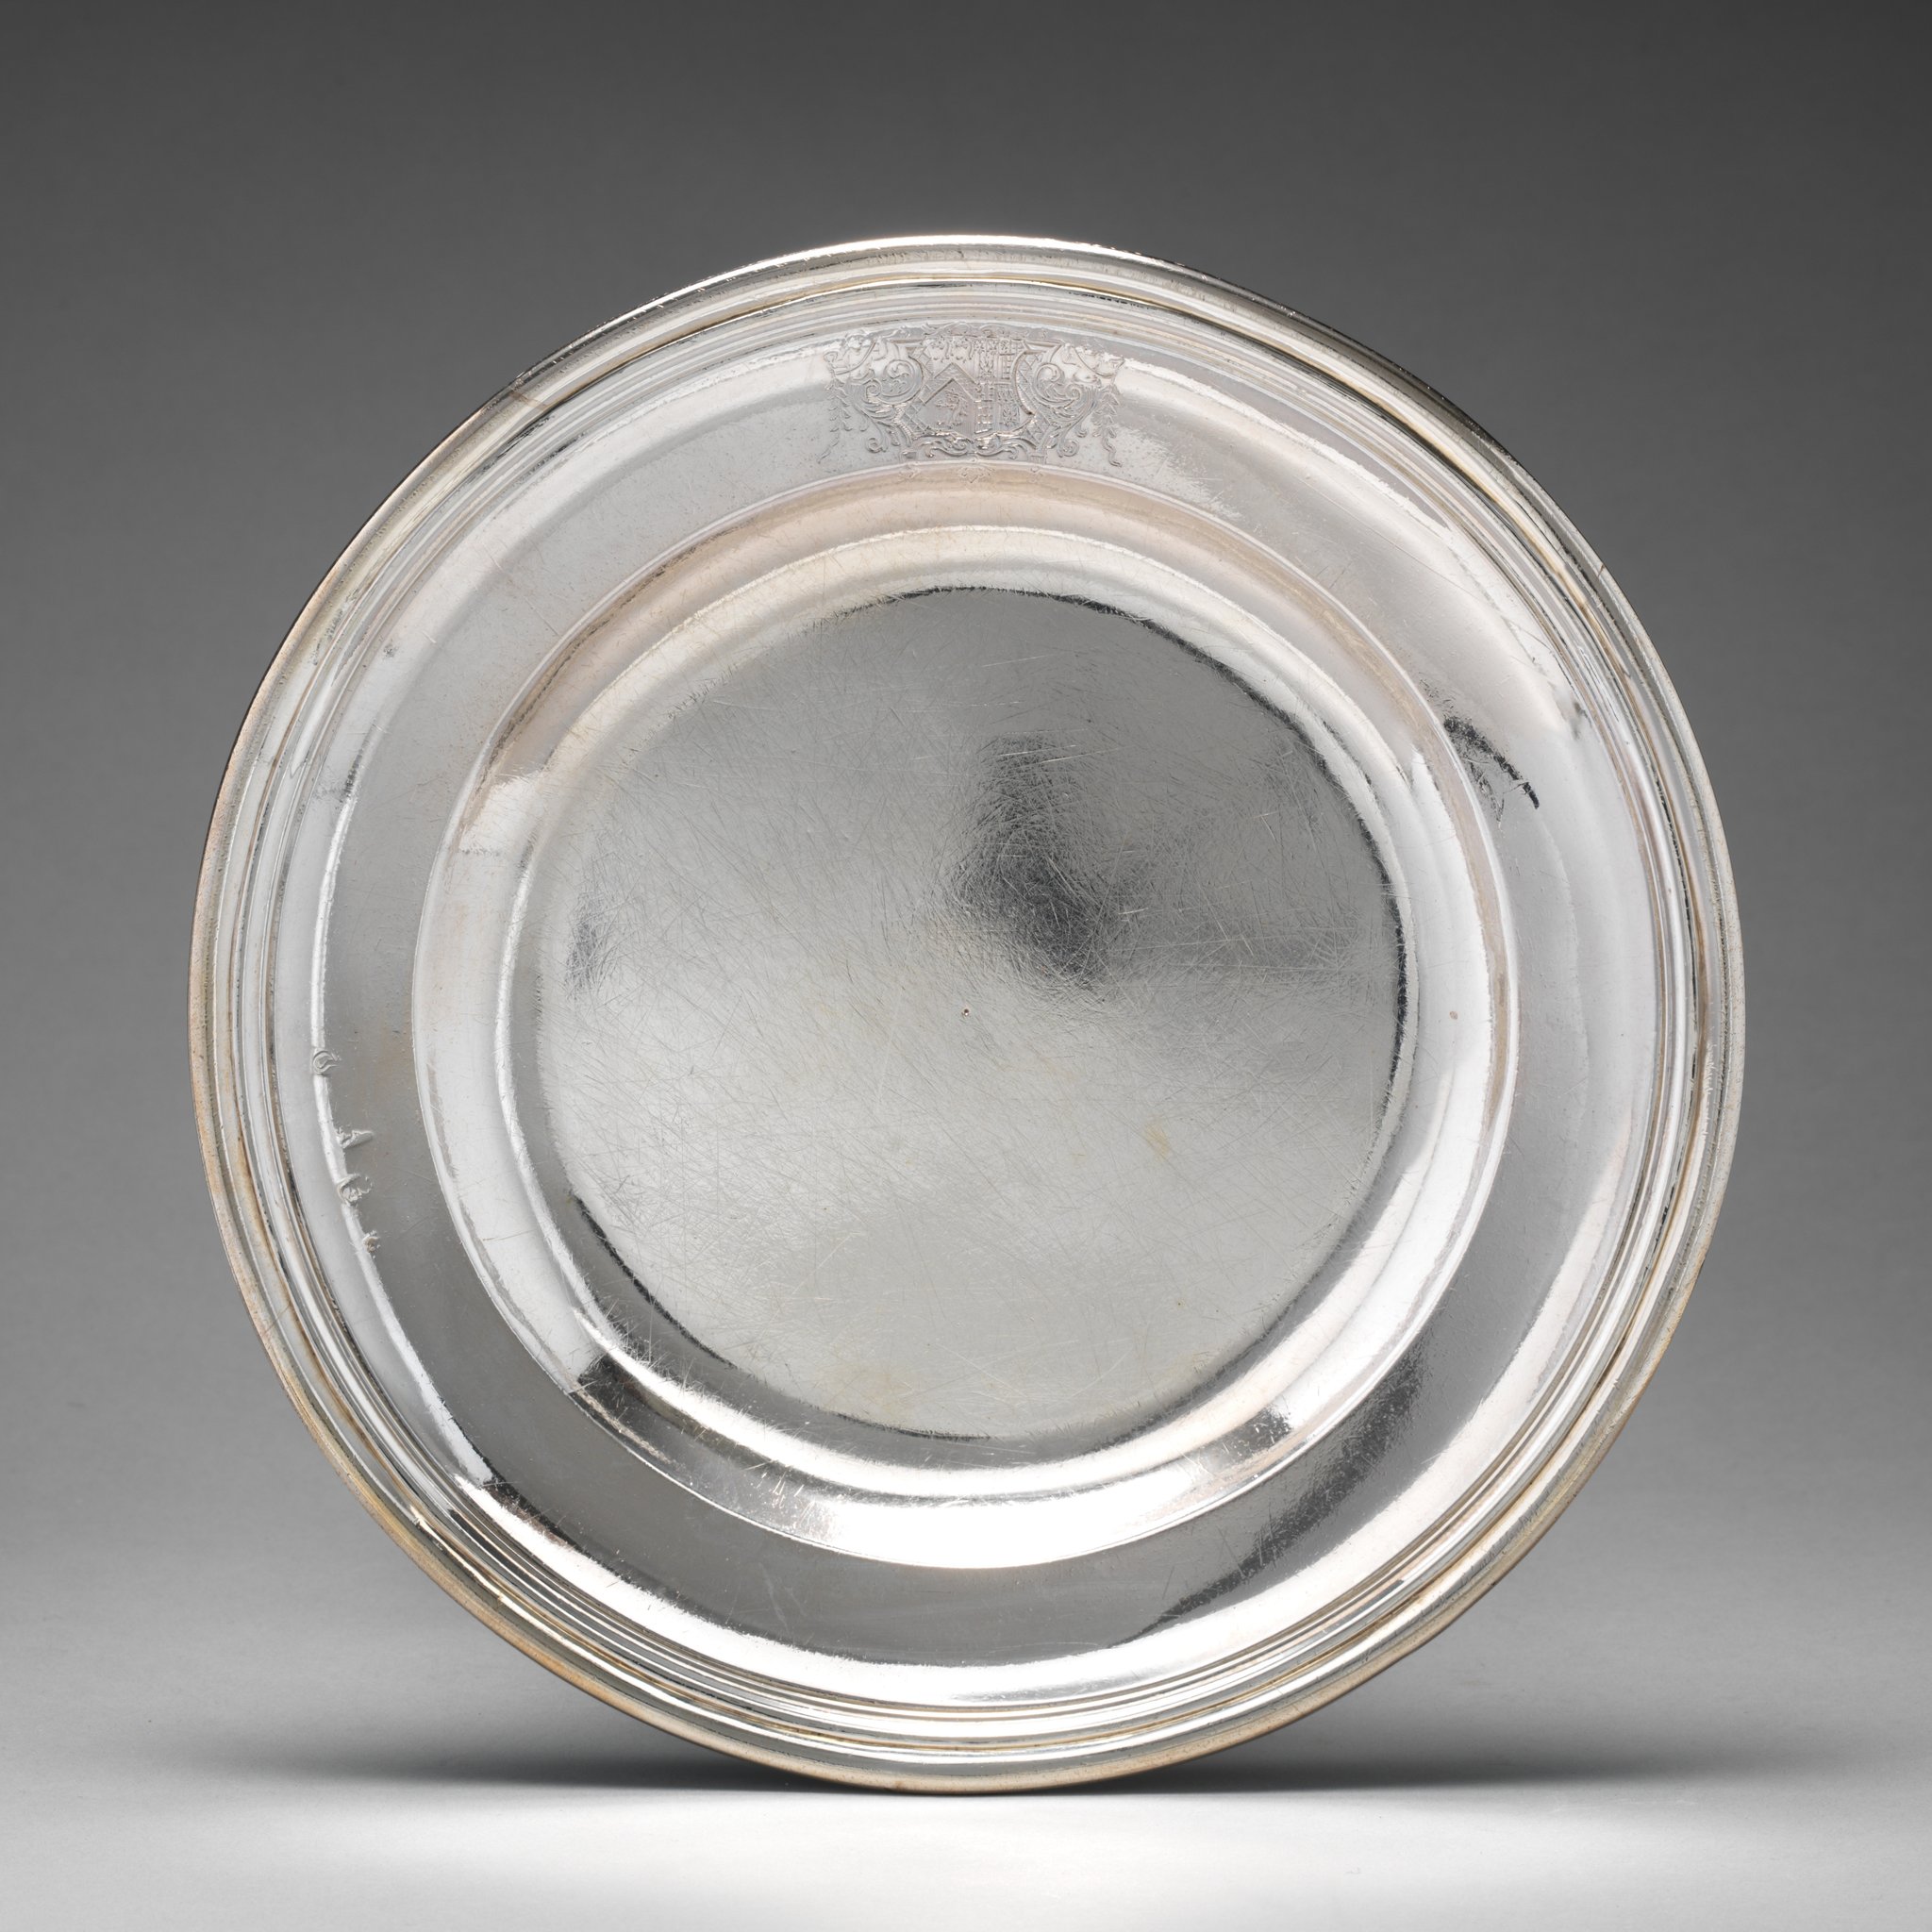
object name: plate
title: Dinner plate with English arms (one of a group of four)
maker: richard bayley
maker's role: maker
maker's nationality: british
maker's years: 1708-1748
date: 1715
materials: silver